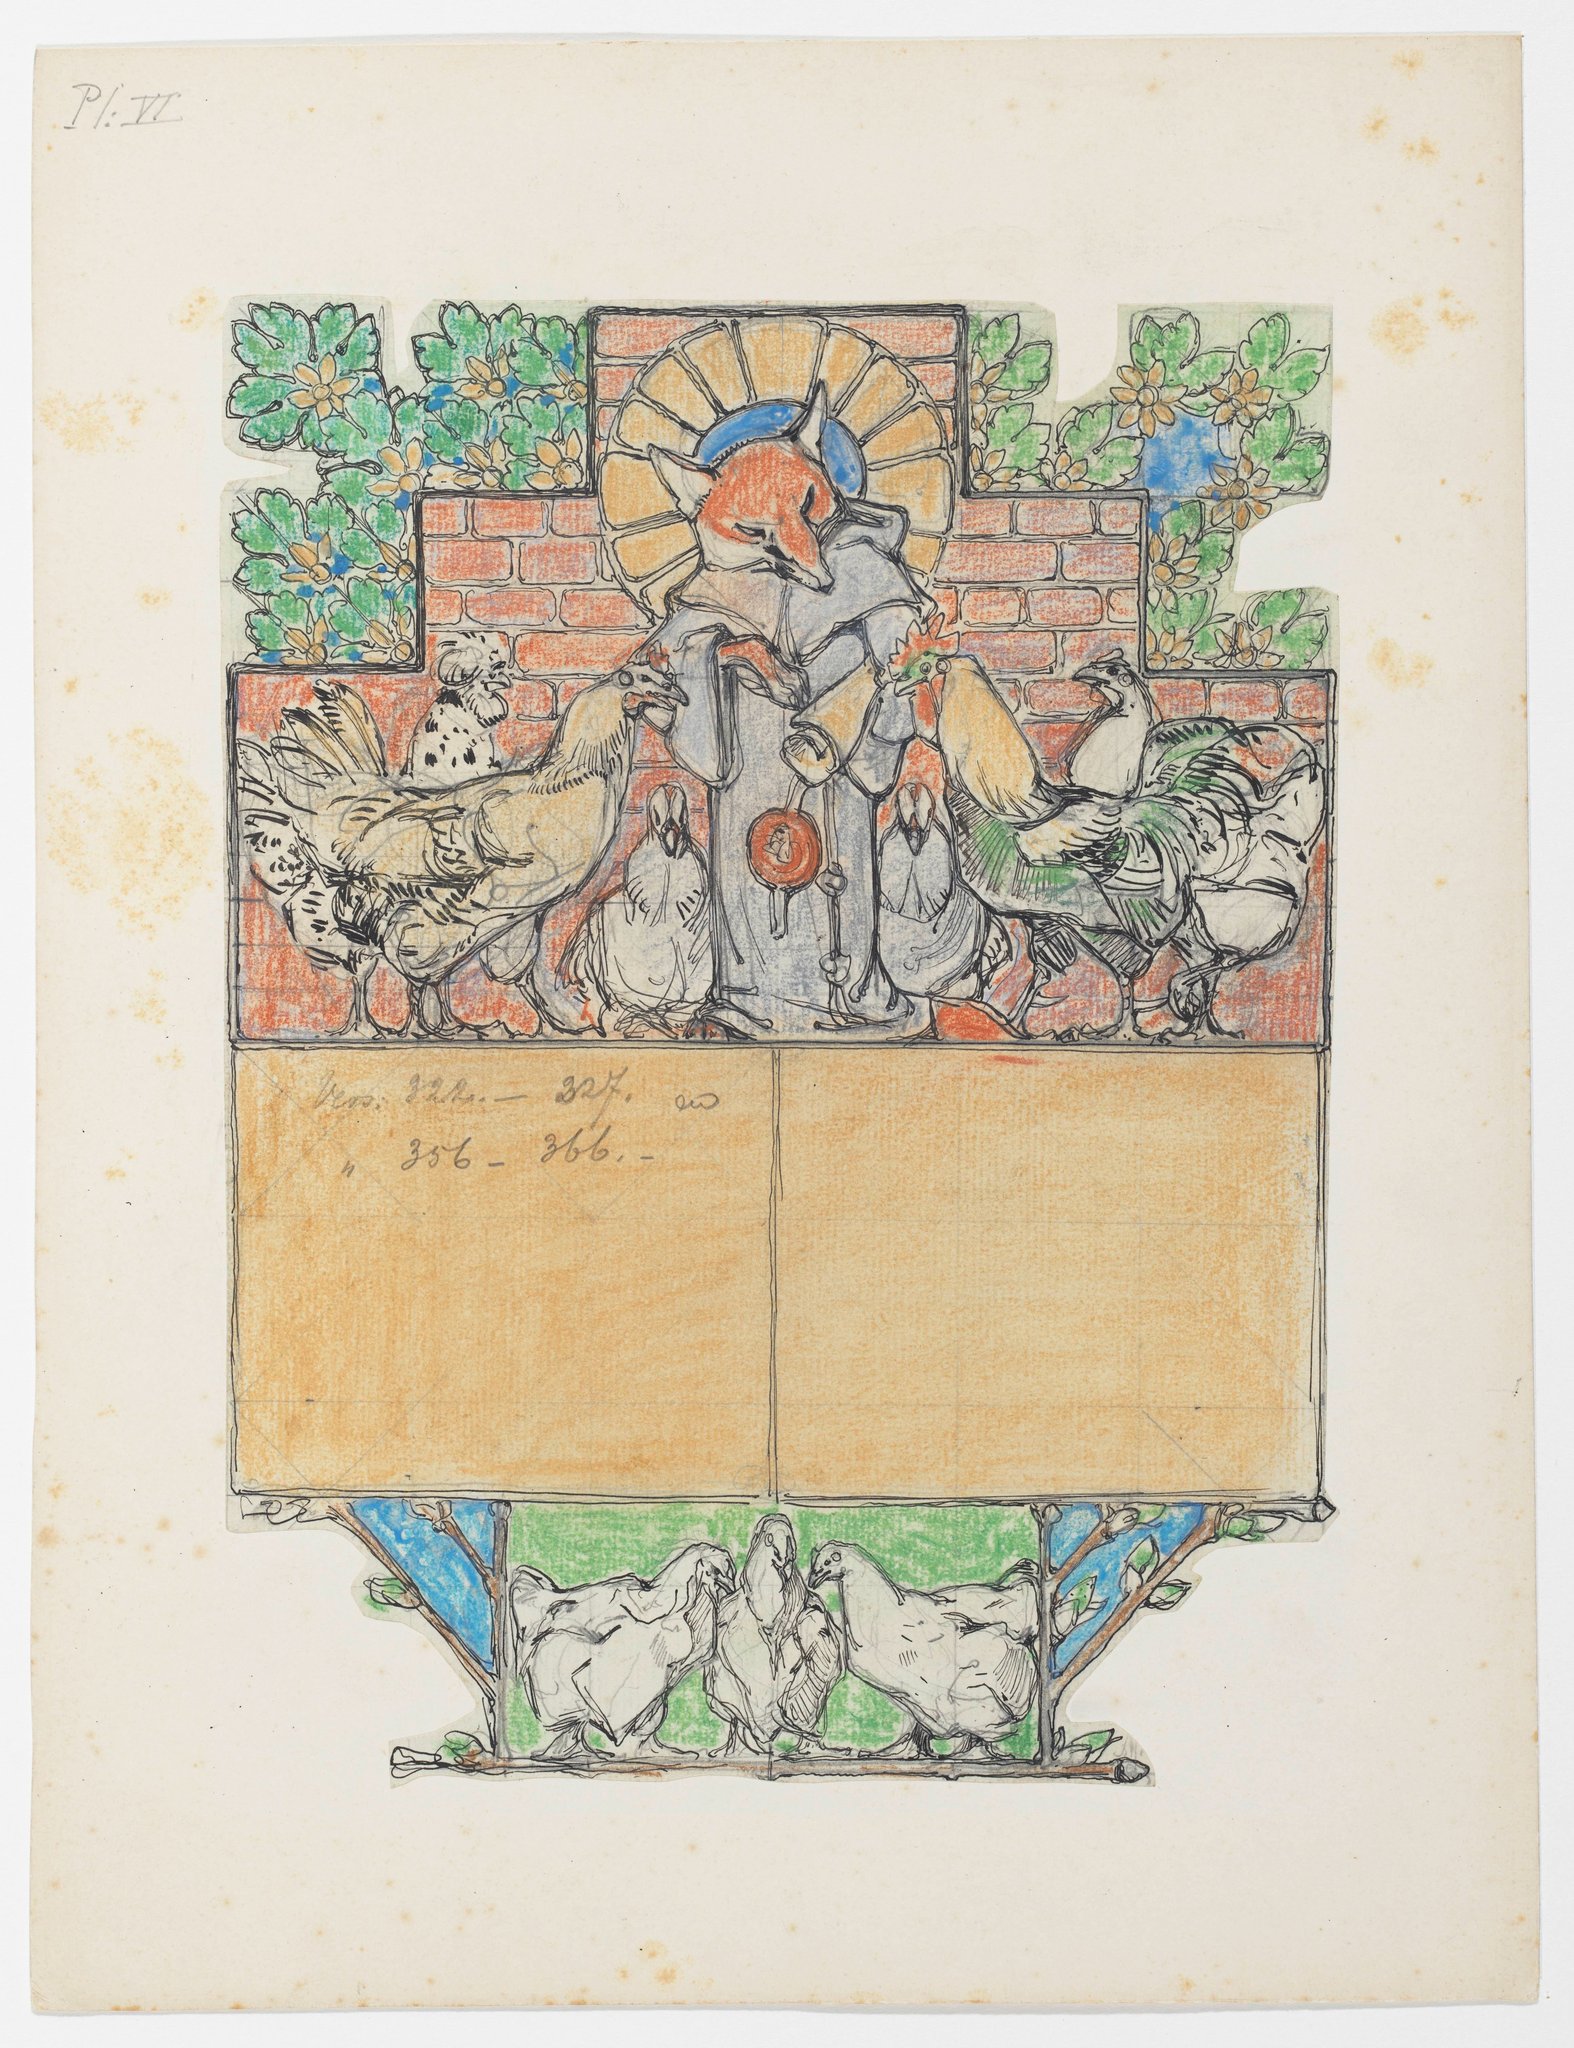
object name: design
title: Reinaert met een brief bij Canteclaer en zijn gezin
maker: bernard willem wierink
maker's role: draughtsman, print maker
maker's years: 1856-1939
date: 1866-1939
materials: cardboard, chalk, ink, paper, pencil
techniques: brush, pen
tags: fable of reynard the fox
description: Ontwerp voor illustratie (fol. 6, tweede ontwerp): Van den Vos Reinaerde; Reinaert, als kluizenaar, met een brief bij Canteclaer en zijn gezin, voor een muur.